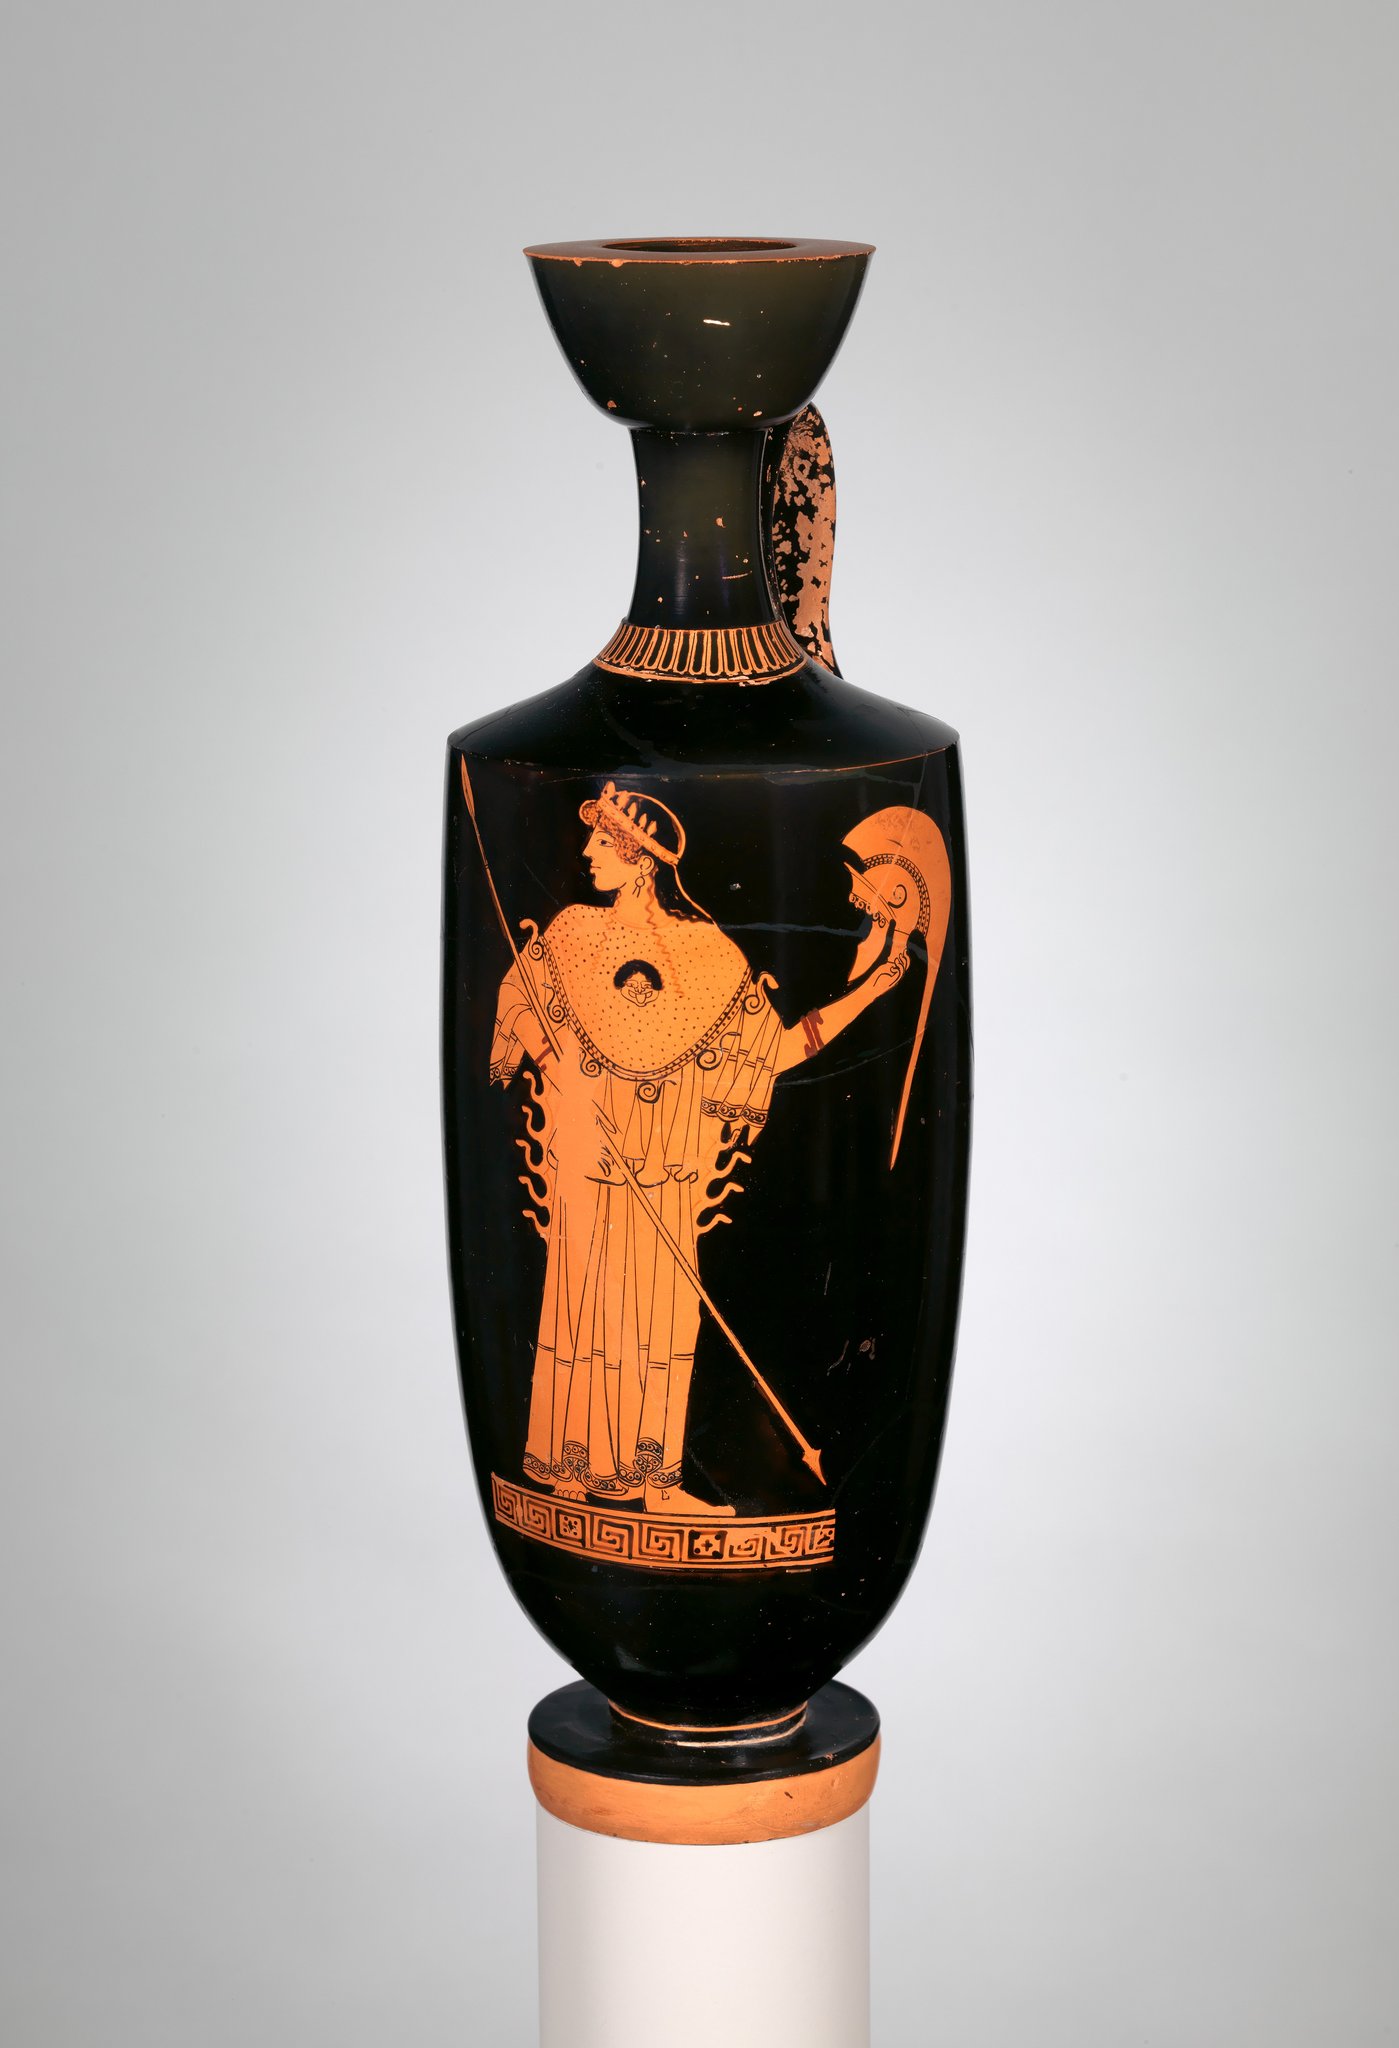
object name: lekythos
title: Terracotta lekythos (oil flask)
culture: greek, attic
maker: tithonos painter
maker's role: artist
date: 480 BCE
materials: terracotta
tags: spears,athena